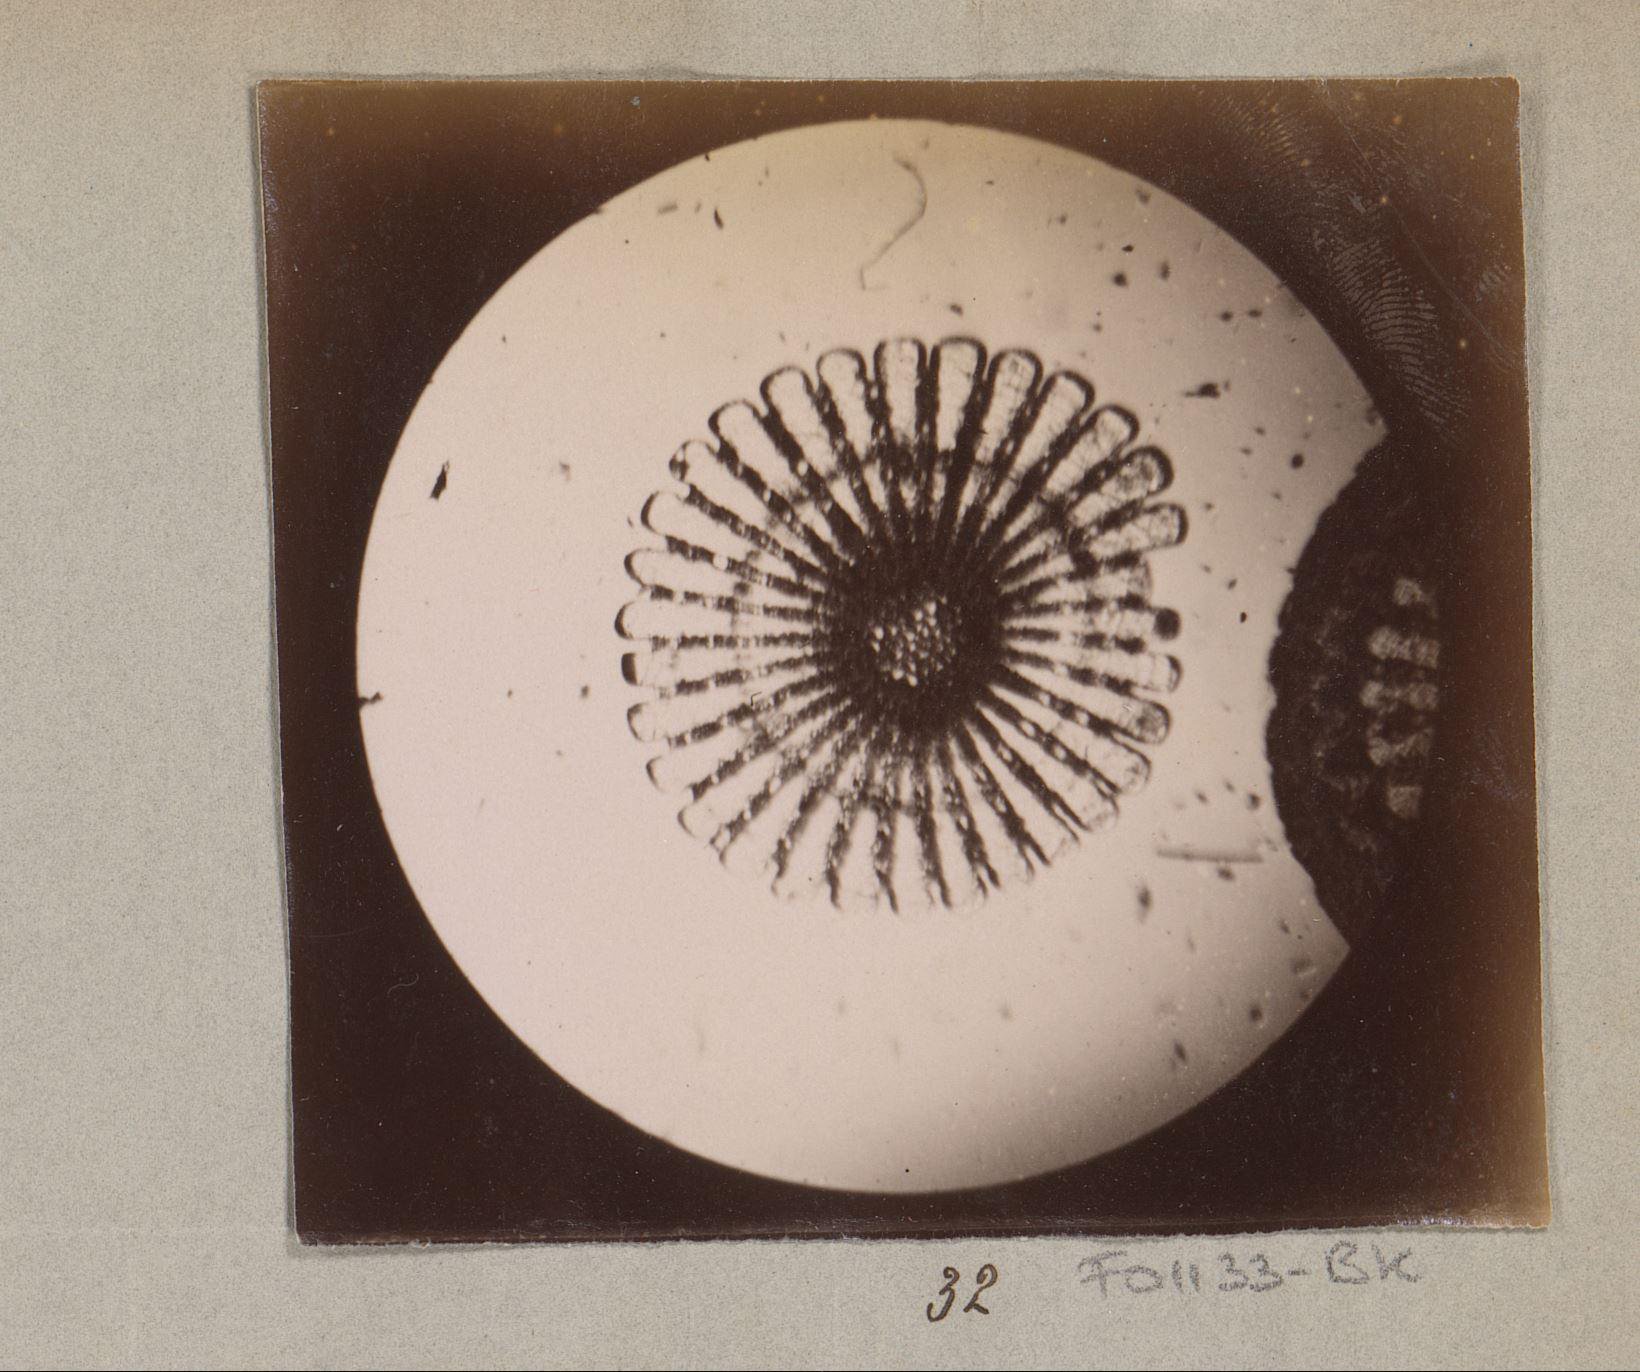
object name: photograph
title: Microscopische opname van een waterstekel, 25 keer vergroot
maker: marinus pieter filbri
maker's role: instrument maker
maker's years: 1852-1917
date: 1887-1888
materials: paper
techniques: albumen print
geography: netherlands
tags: plants; vegetation, netherlands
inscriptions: number: ‘32’, inscription: ‘No. 32. id. waterstekel, id., id., bemerking id.’